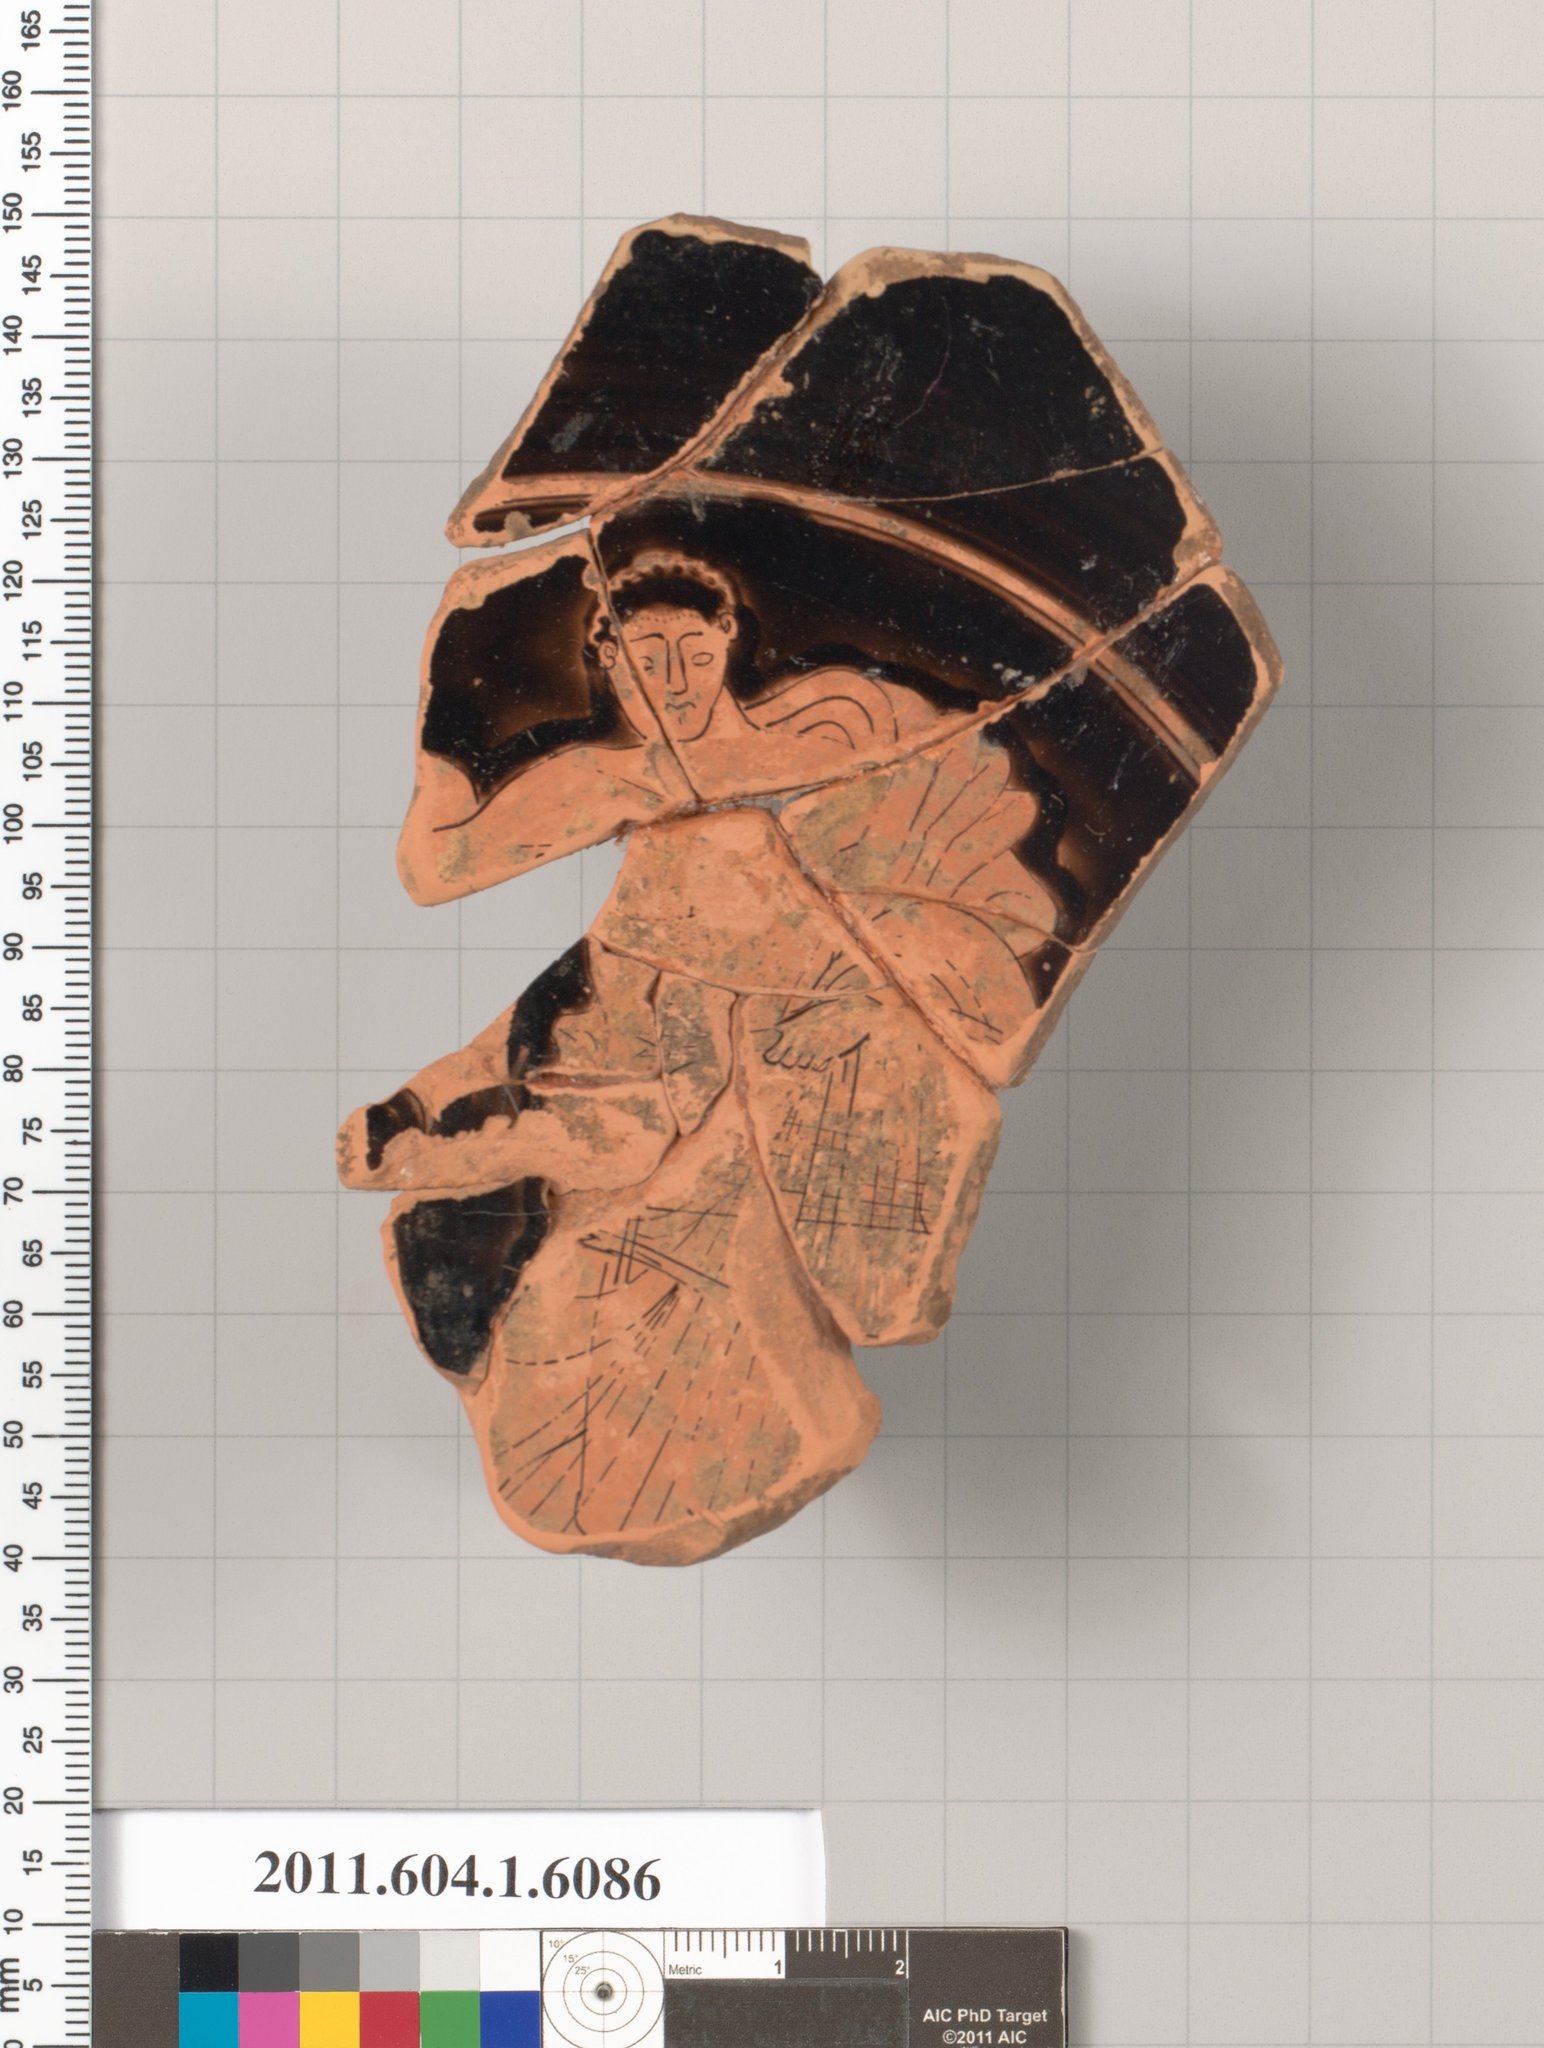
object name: kylix fragment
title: Terracotta fragment of a kylix (drinking cup)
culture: greek, attic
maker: apollodoros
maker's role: artist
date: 500-490 BCE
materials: terracotta